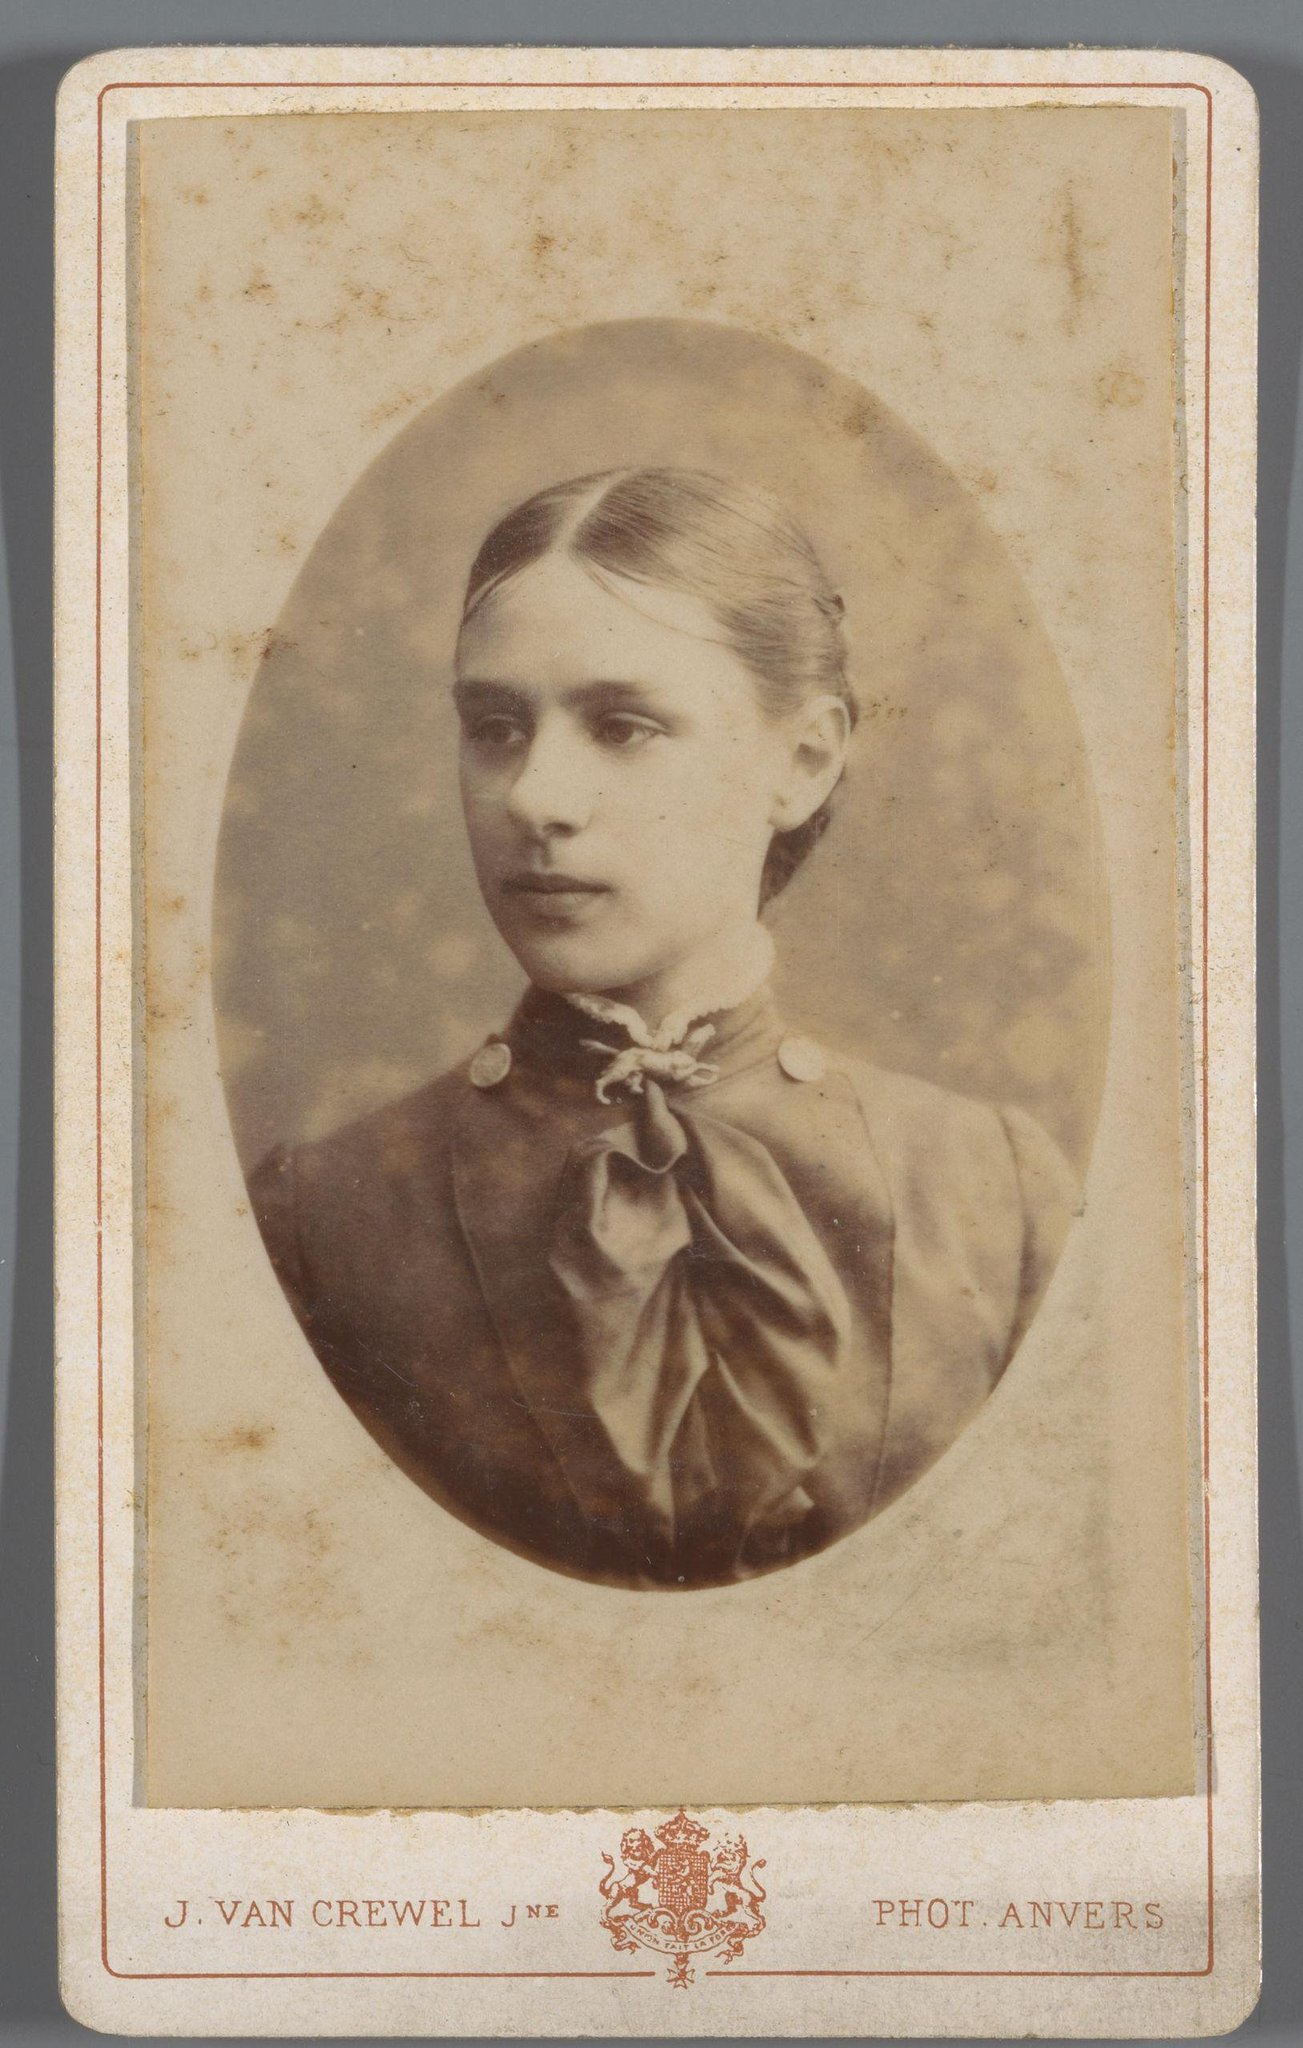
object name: carte de visite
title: Portret van een onbekende vrouw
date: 1881-1905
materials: cardboard, celluloid, paper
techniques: albumen print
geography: antwerp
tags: historical persons - bb - woman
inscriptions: inscription: ‘BREVET/ D'/ INVENTION/ MÉDAILLE D'ARGENT/ A L'EXPOSITION RUBENS 1881/ OBTENUE POUR LE PROCÉDÉ INSTANTANÉ/ J. VAN CREWEL JEUNE/ PHOTOGRAPHE BREVETÉ/ 48, Rue du Pélican 48/ en face de la Gare/ ANVERS/ Galerie de Pose dans le Jardin./ D. HUTINET, PARIS.’